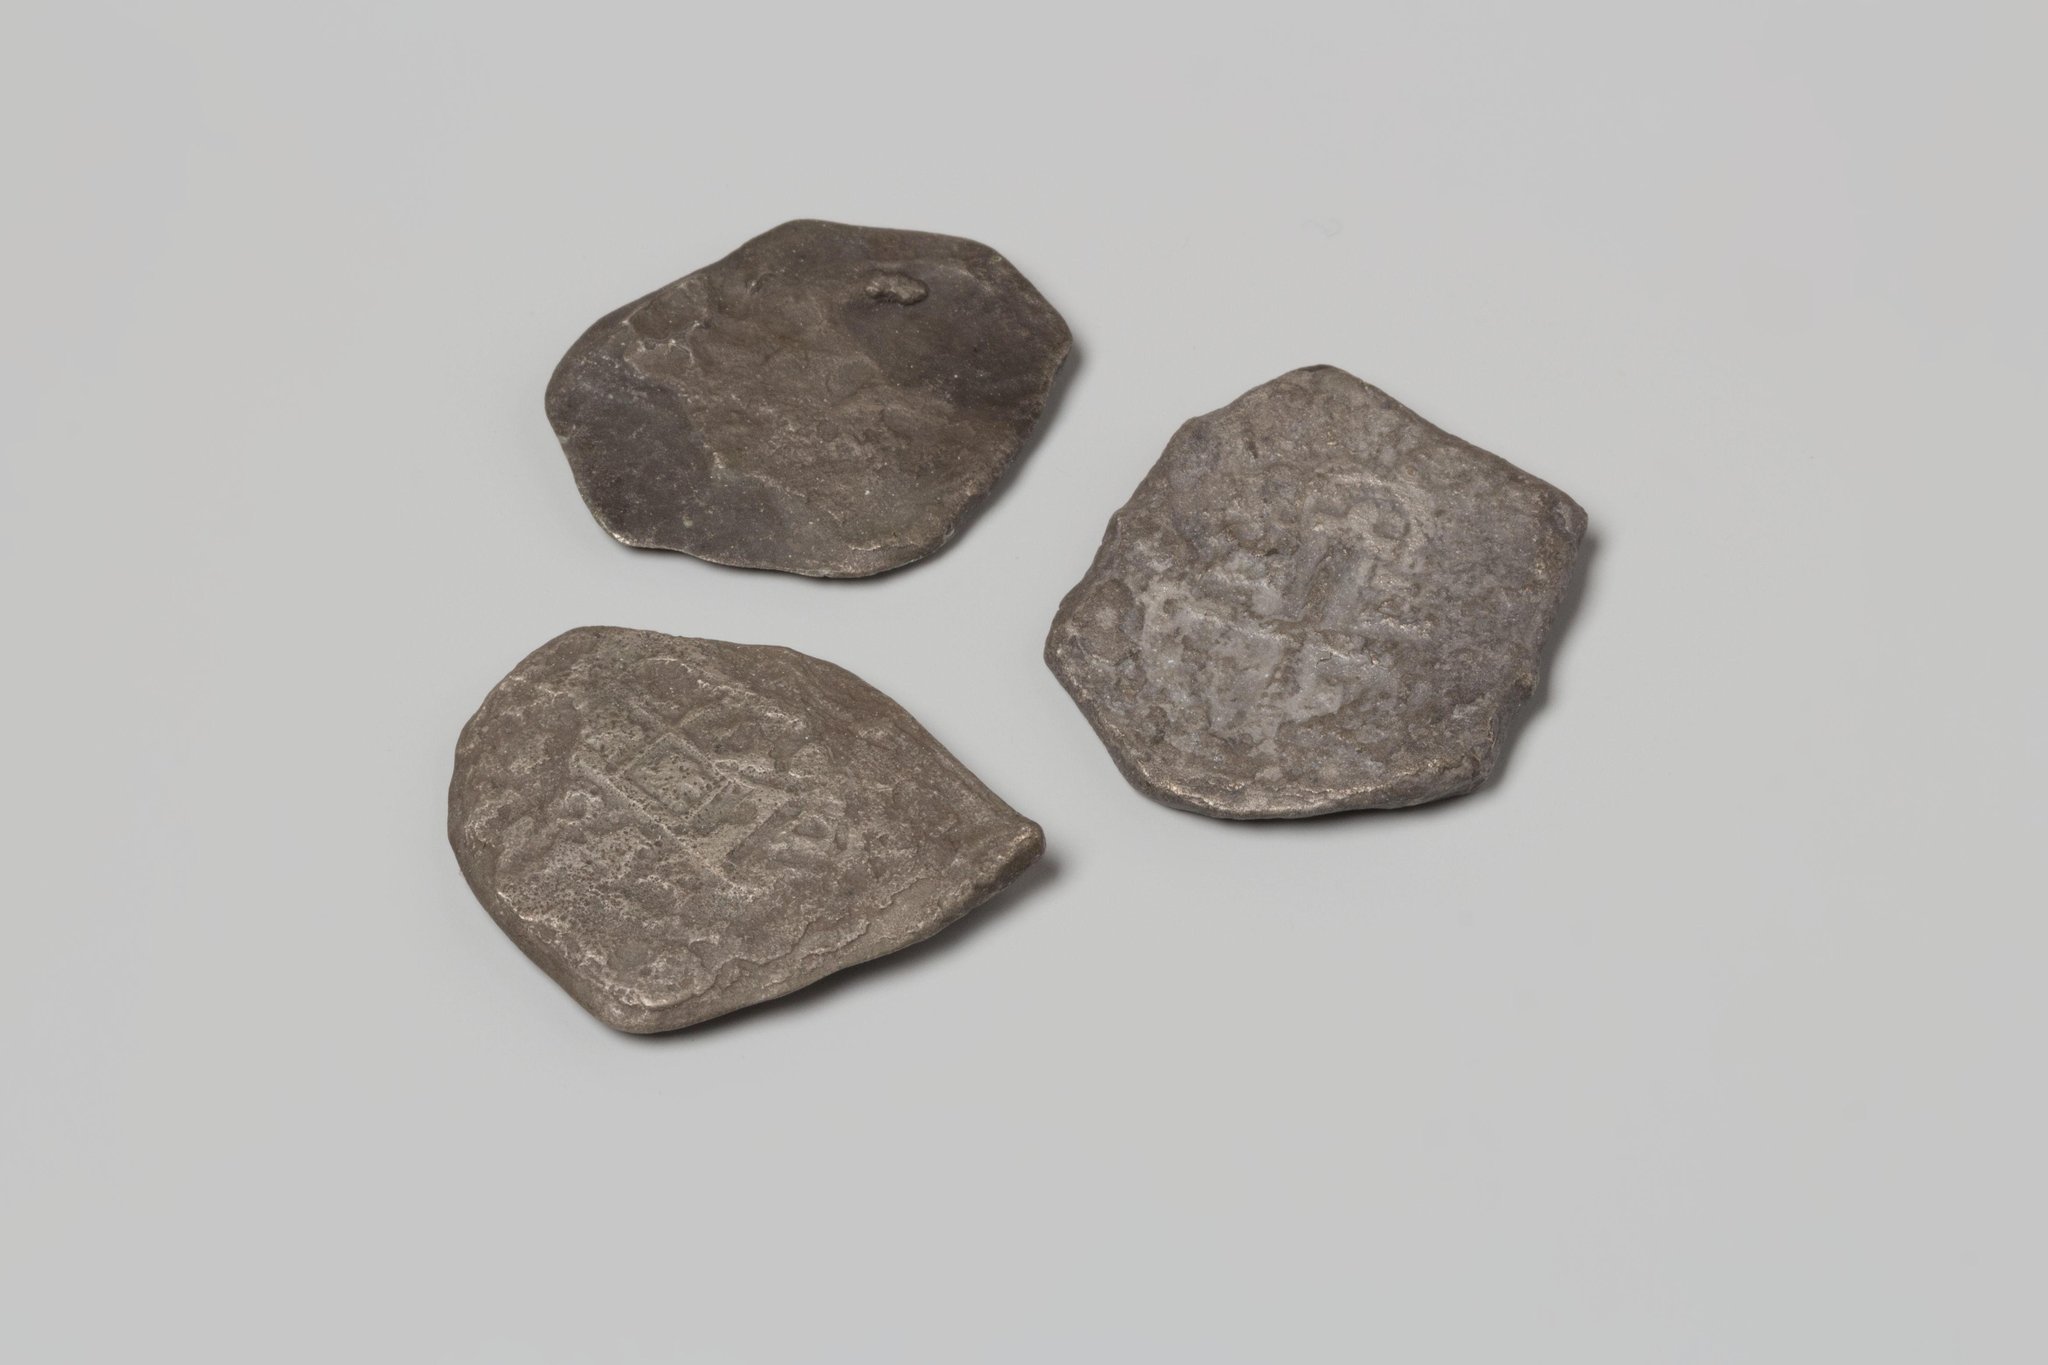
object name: coin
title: Munten uit het wrak van de in 1735 vergane Oost-Indiëvaarder 't Vliegend Hart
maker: Anonymous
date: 1700-1735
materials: silver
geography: central america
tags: 't vliegend hart (schip), verenigde oostindische compagnie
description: Het waren oorspronkelijk 4 munten, ingepakt in een dikke corrosielaag. Tijdens de electrolyse viel er een uit elkaar. Het is Zuidamerikaans zilvergeld, realen. Ze zijn min of meer vierkant en plat en werden ooit met de hand geknipt. Aan een zijde is een afbeelding van een kruis te zien, aan de andere zijde het wapen van de koning van Spanje. Ze werden tussen 1729 en 1733 vervaardigd.